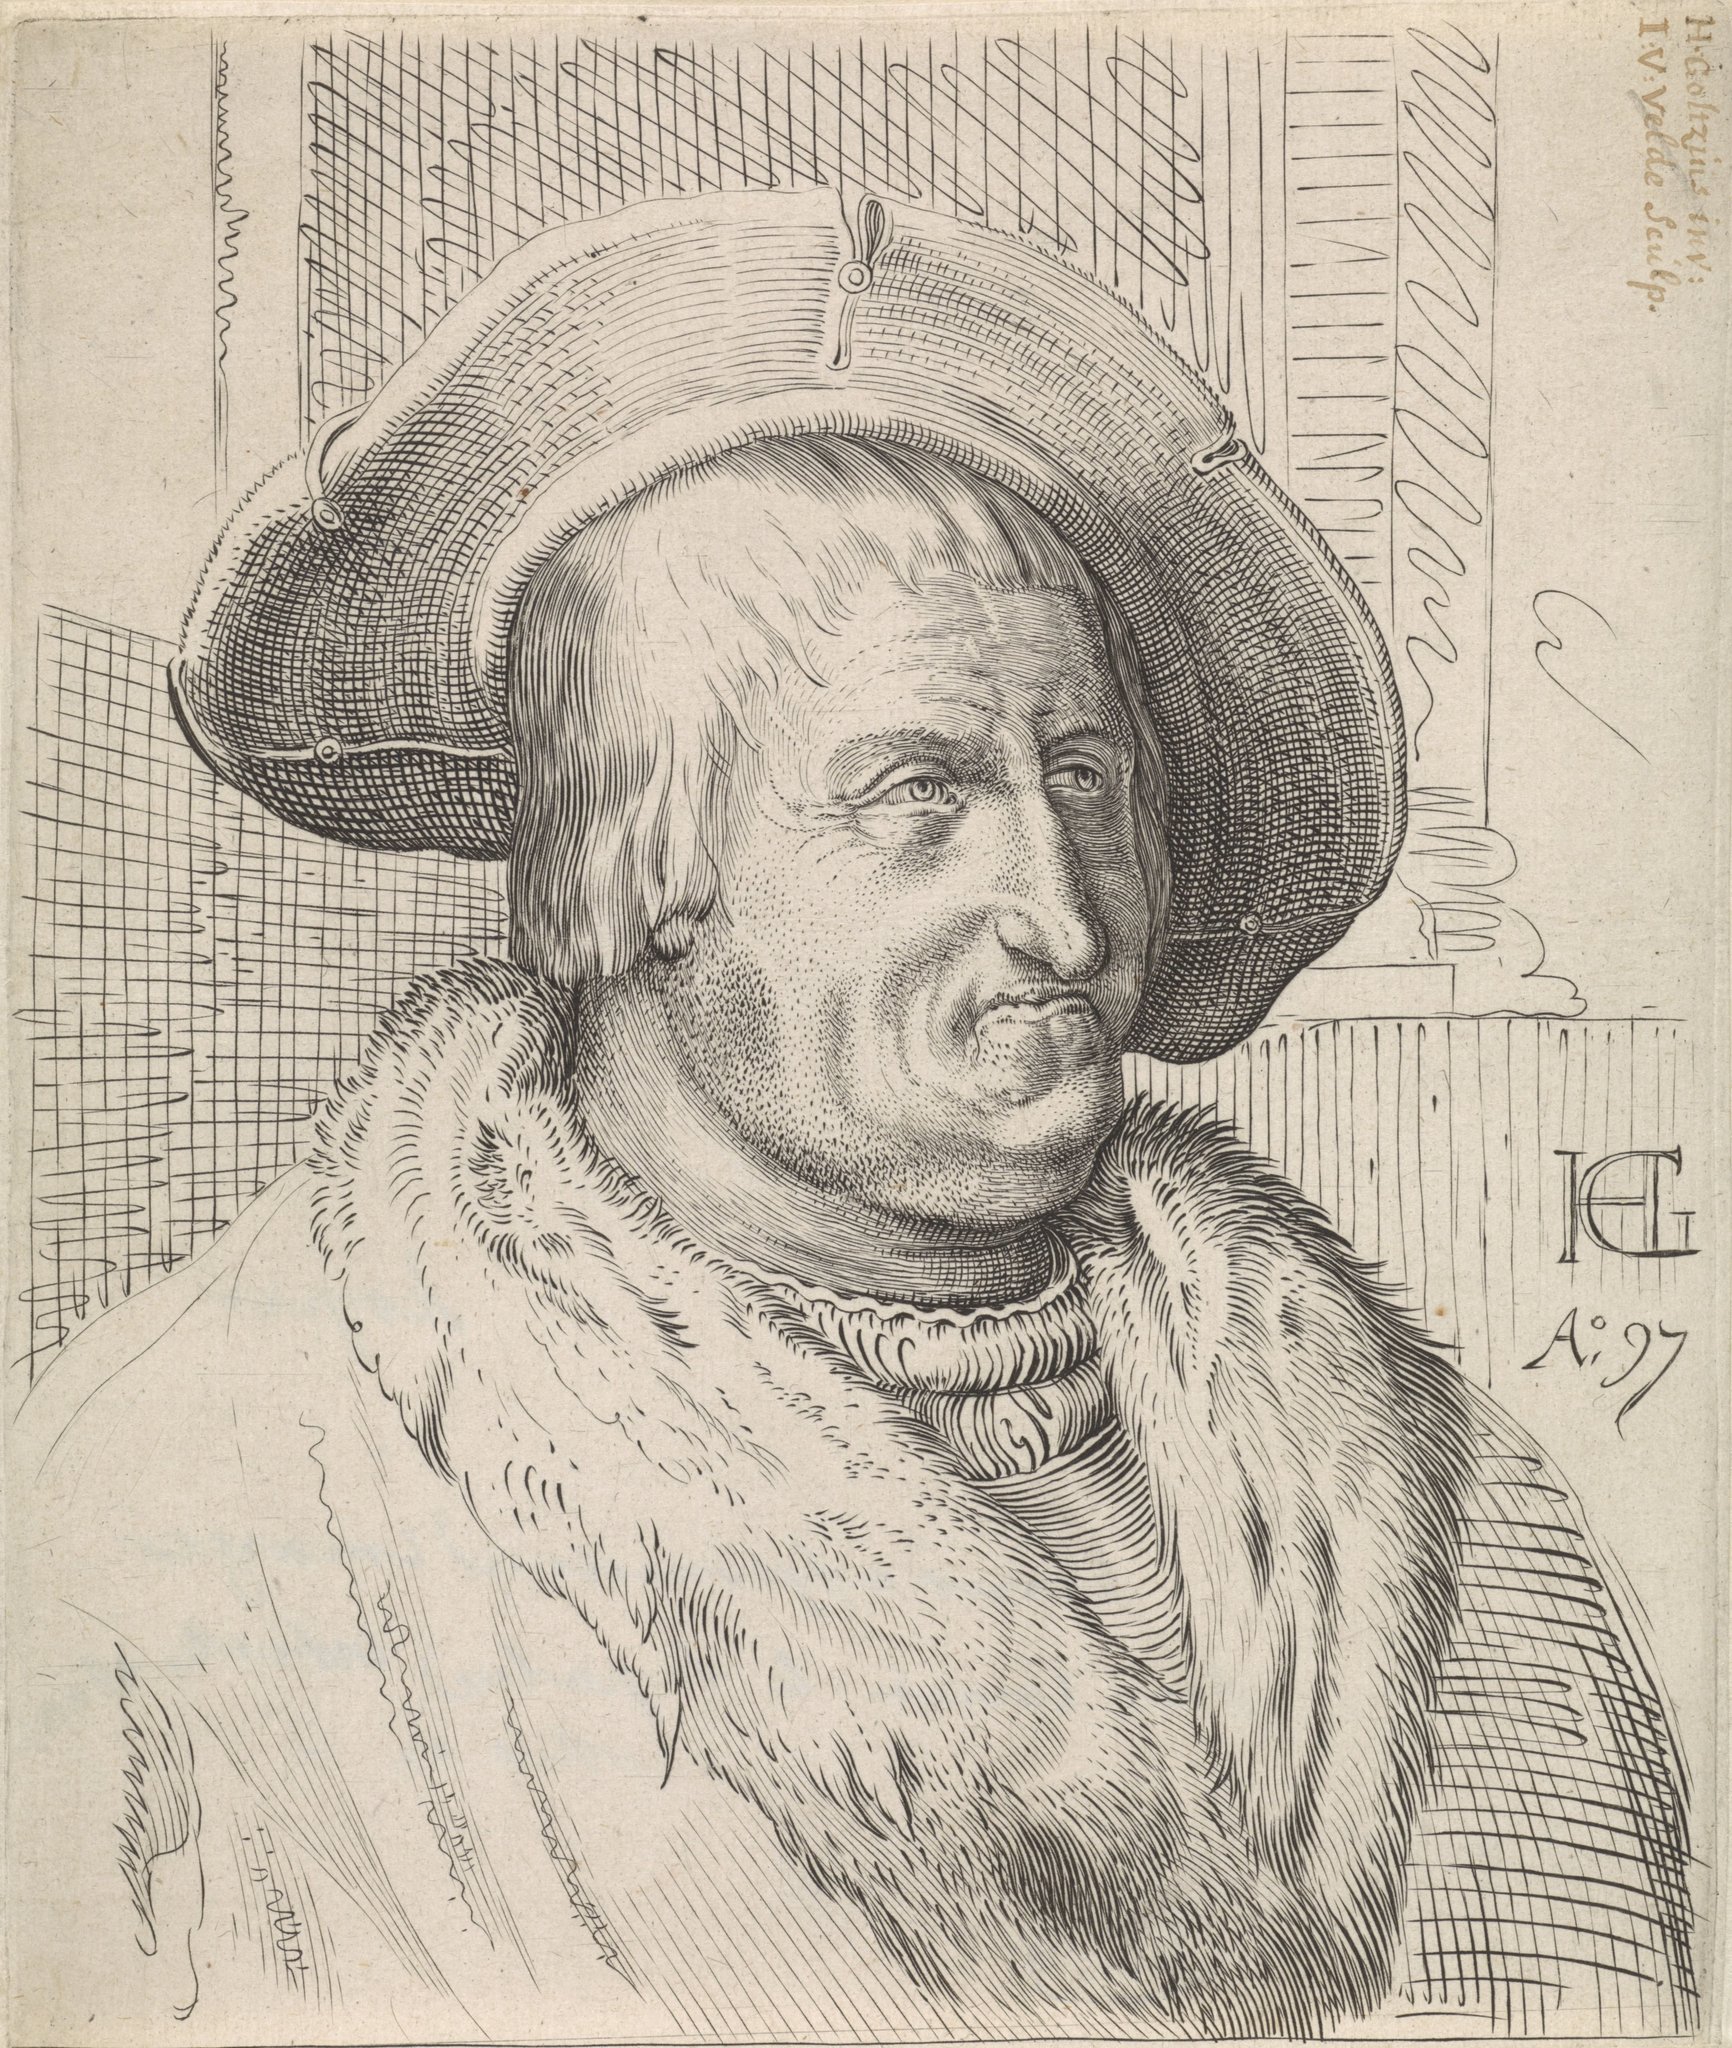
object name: print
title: Portret van een oude man met hoed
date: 1597-1652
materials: paper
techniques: engraving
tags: head-gear: hat (+ men's clothes)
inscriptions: collector's mark: Lugt 2228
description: Fantasieportret van een oude man met hoed op het hoofd en gekleed in een mantel met bontkraag.